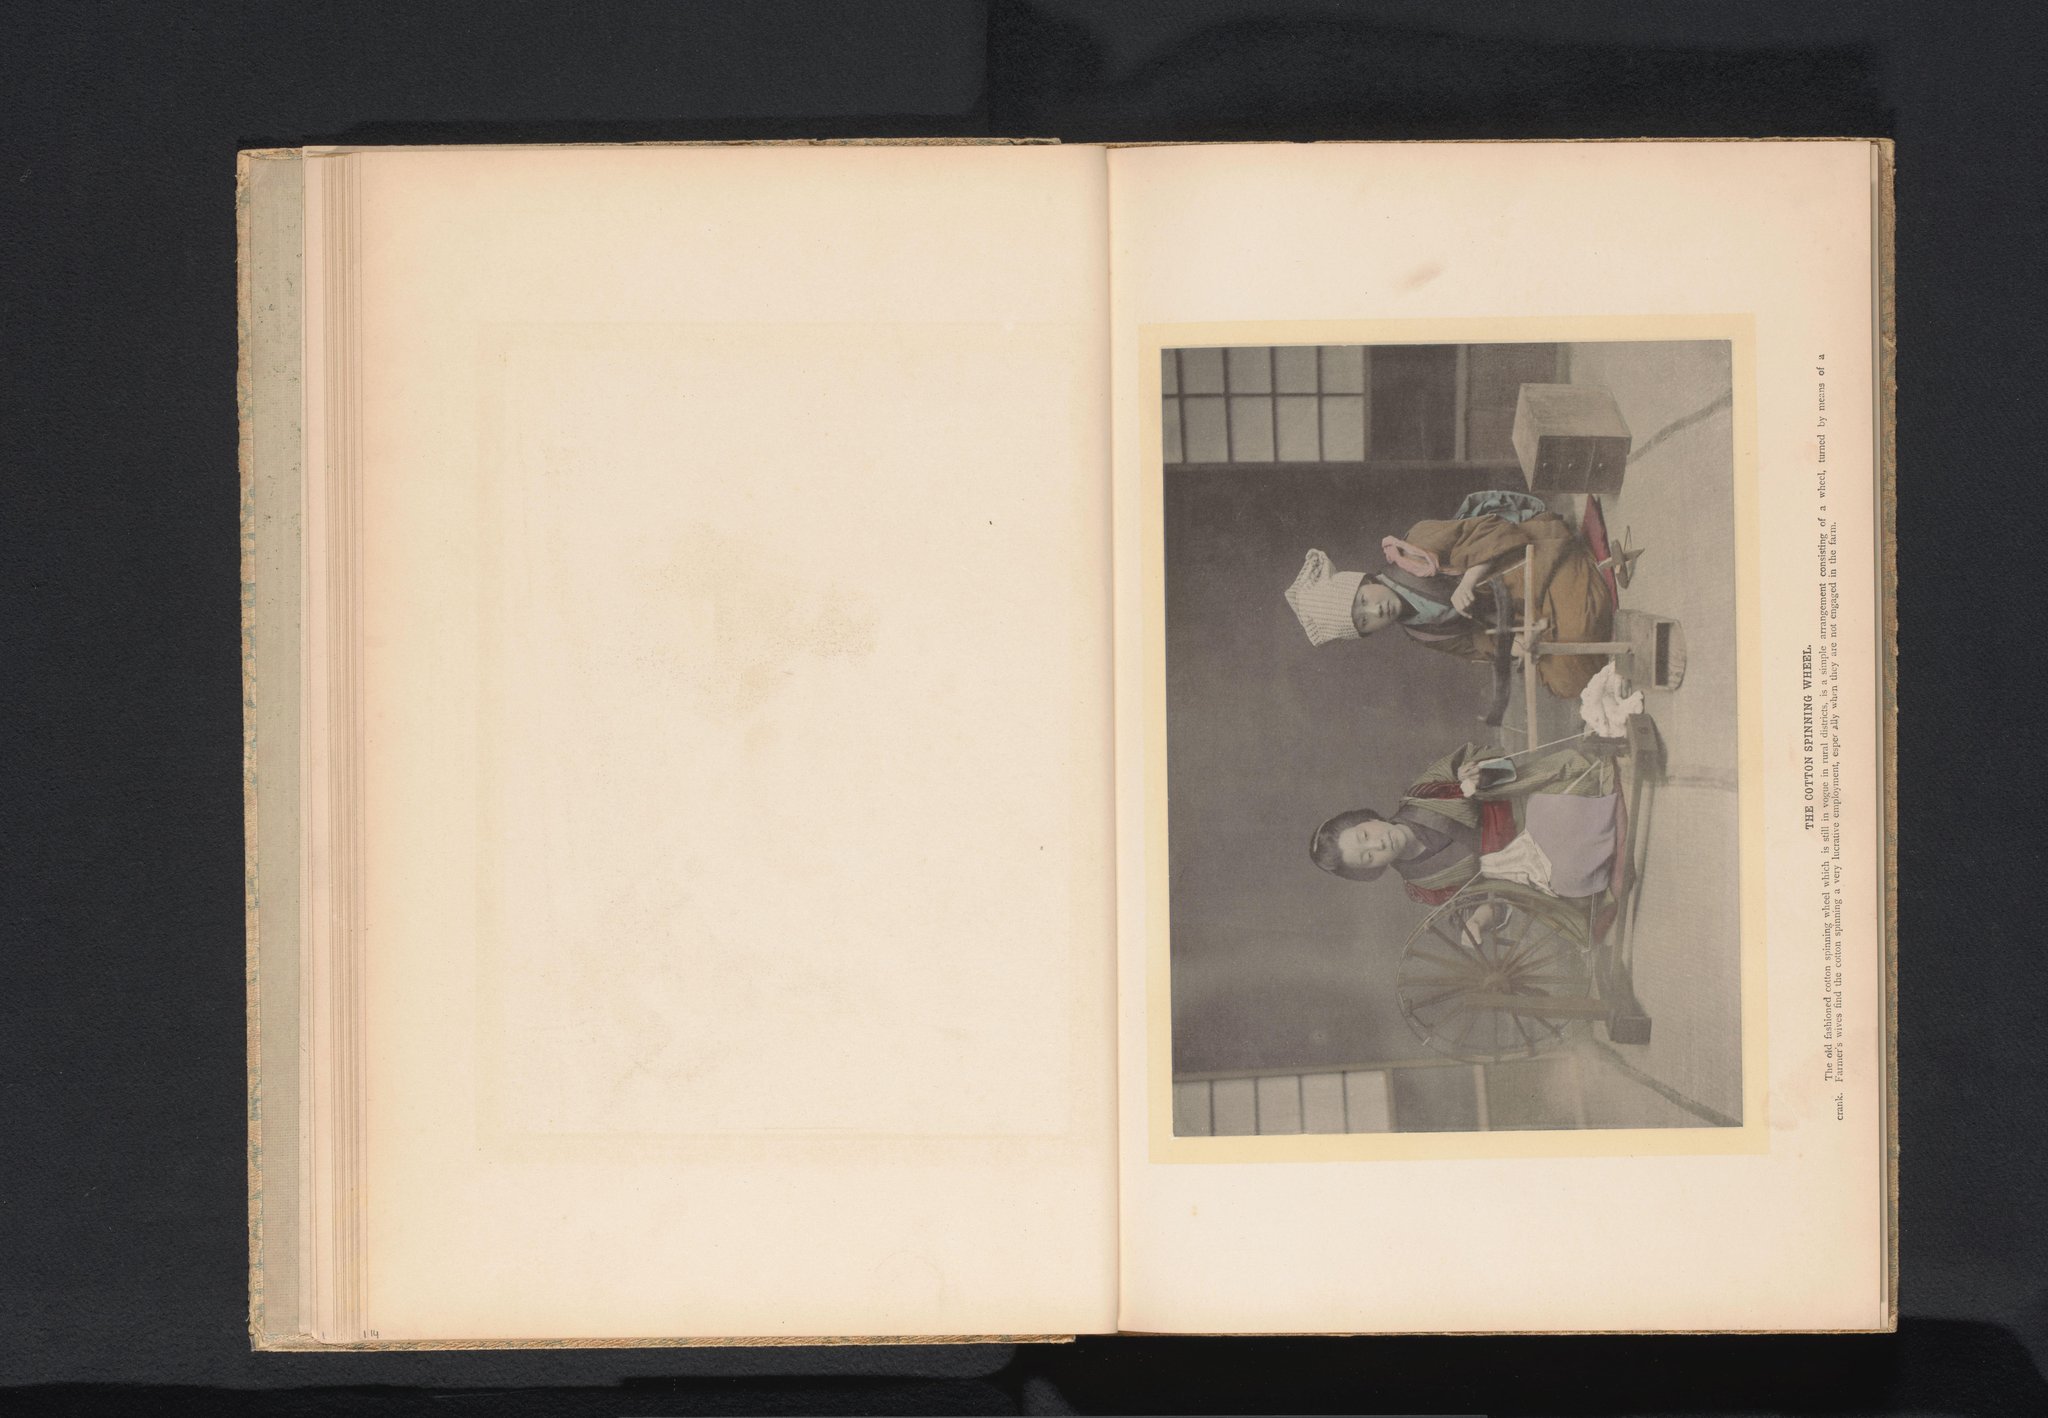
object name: page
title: The Cotton Spinning Wheel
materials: paper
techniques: photograph, lithograph, hand coloring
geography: japan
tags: spinning-wheel (+ women (labourers)), japan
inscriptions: inscription: ‘The old (...) the farm.’